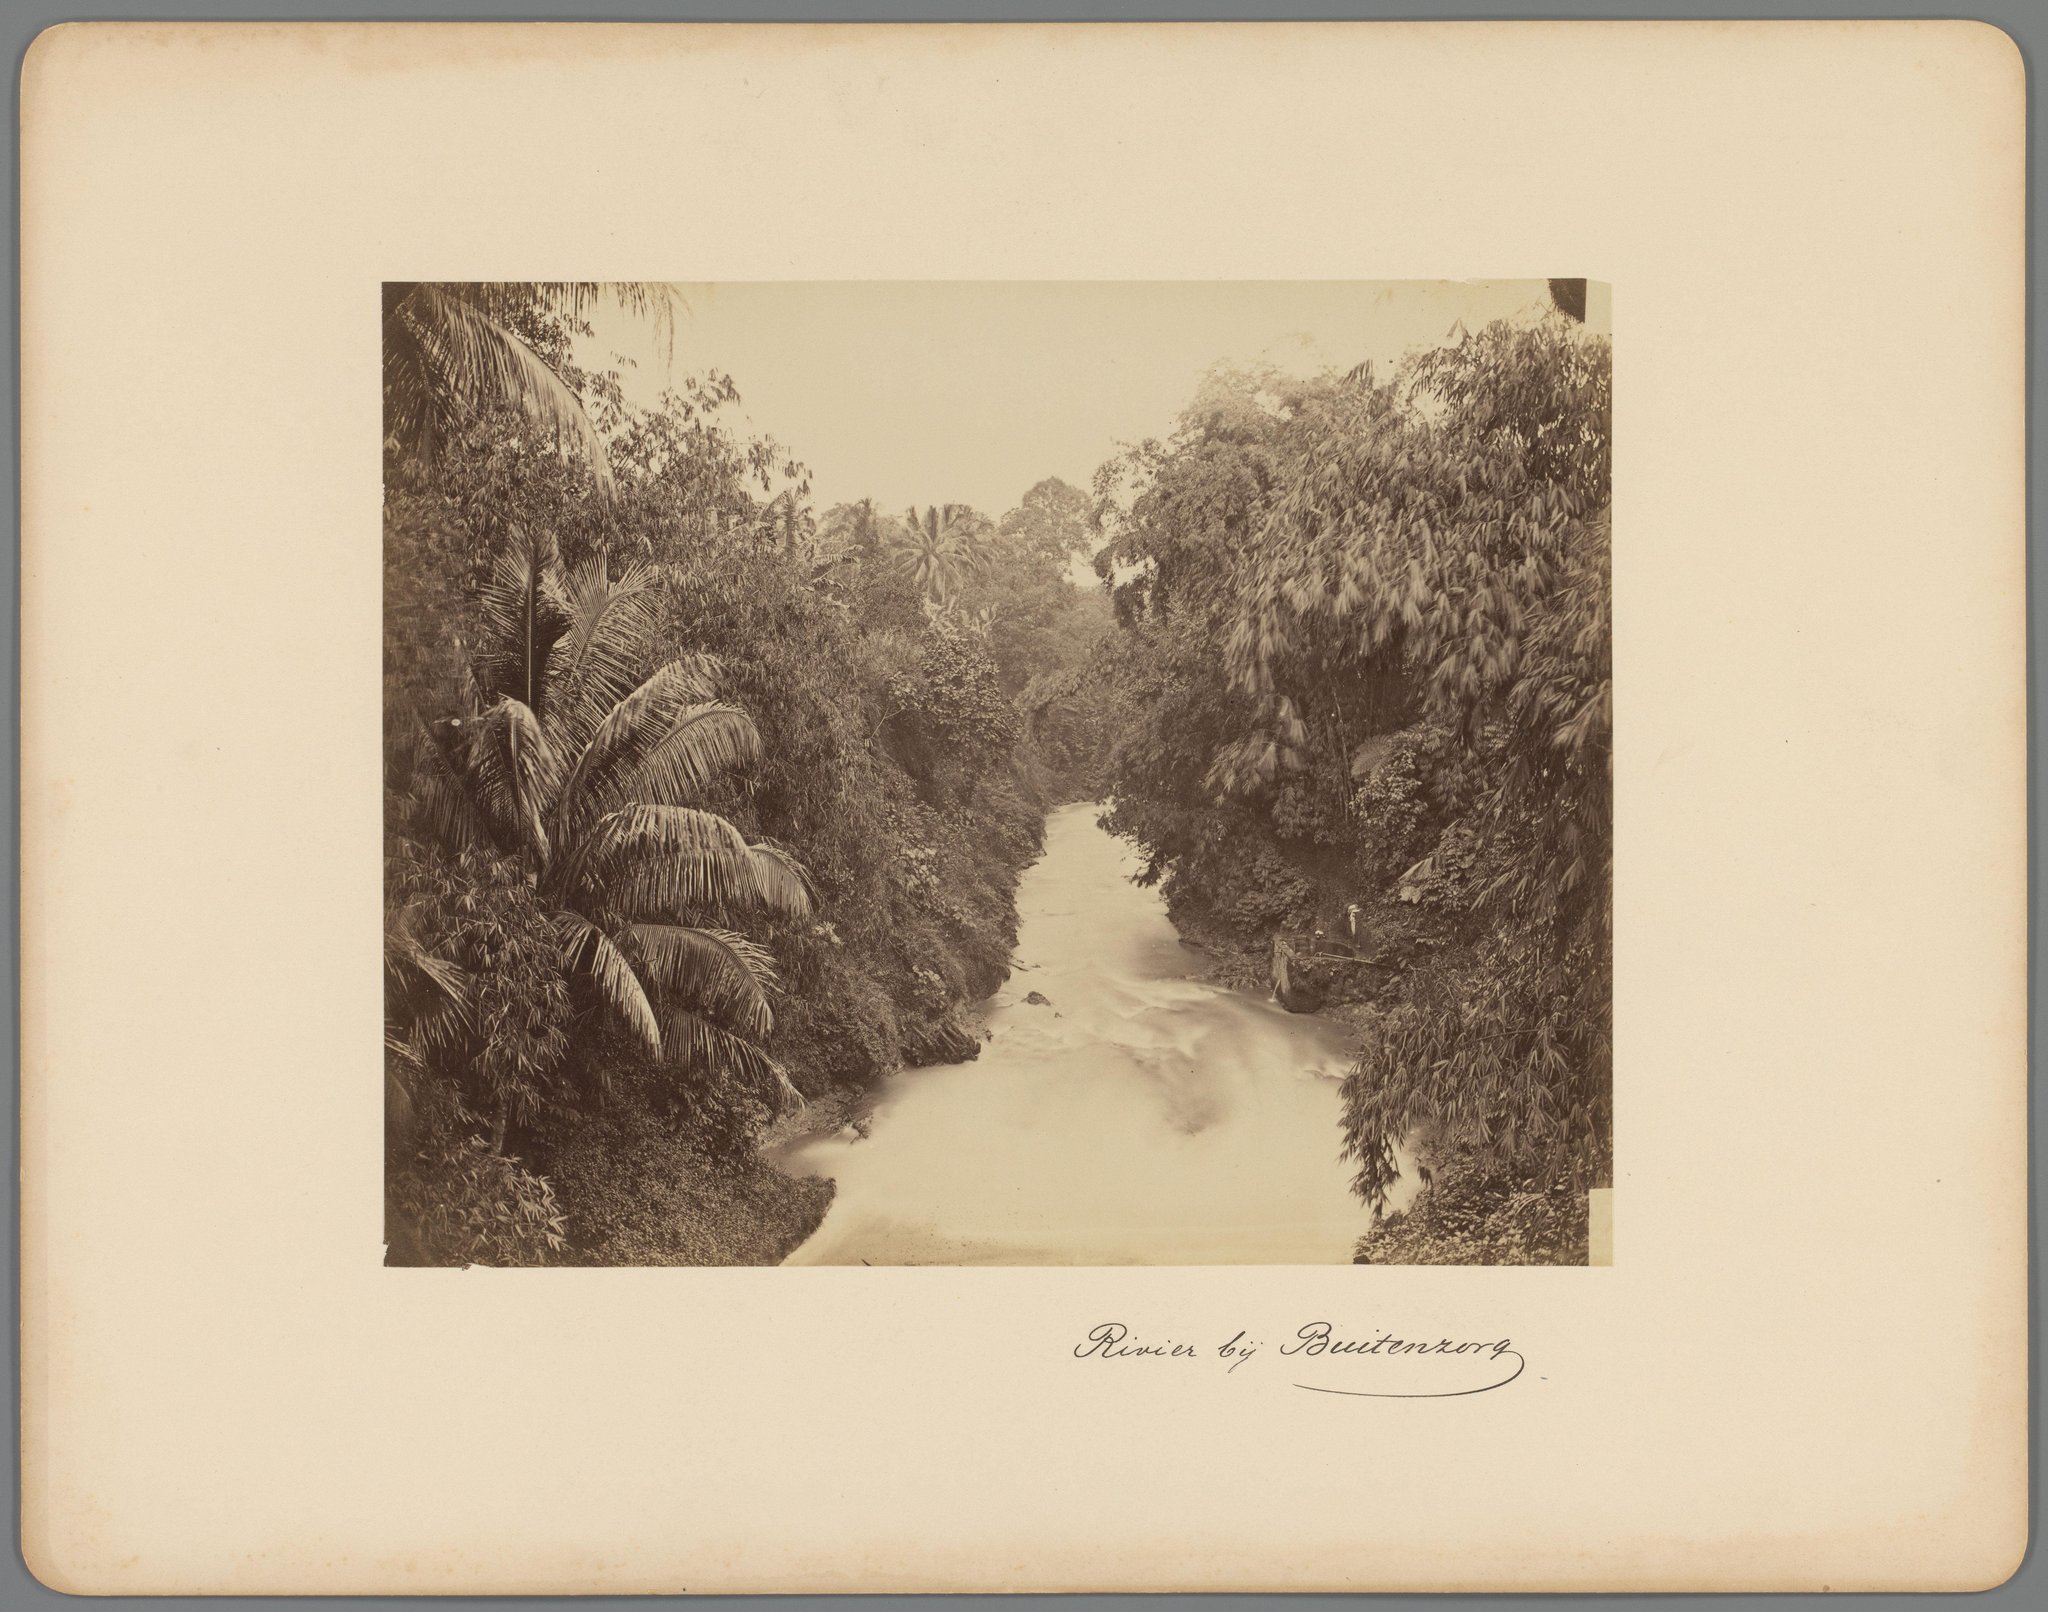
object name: photograph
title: Rivier bij Buitenzorg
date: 1857-1908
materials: cardboard, paper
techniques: albumen print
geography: buitenzorg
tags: river, landscapes in tropical and sub-tropical regions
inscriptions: number: ‘6’, inscription: ‘PHOTOGRAFIEEN VAN NED: INDIE BATAVIA’, inscription: ‘FOTO’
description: Deze foto zat oorspronkelijk in prentenkabinet RP-F-AA3192.